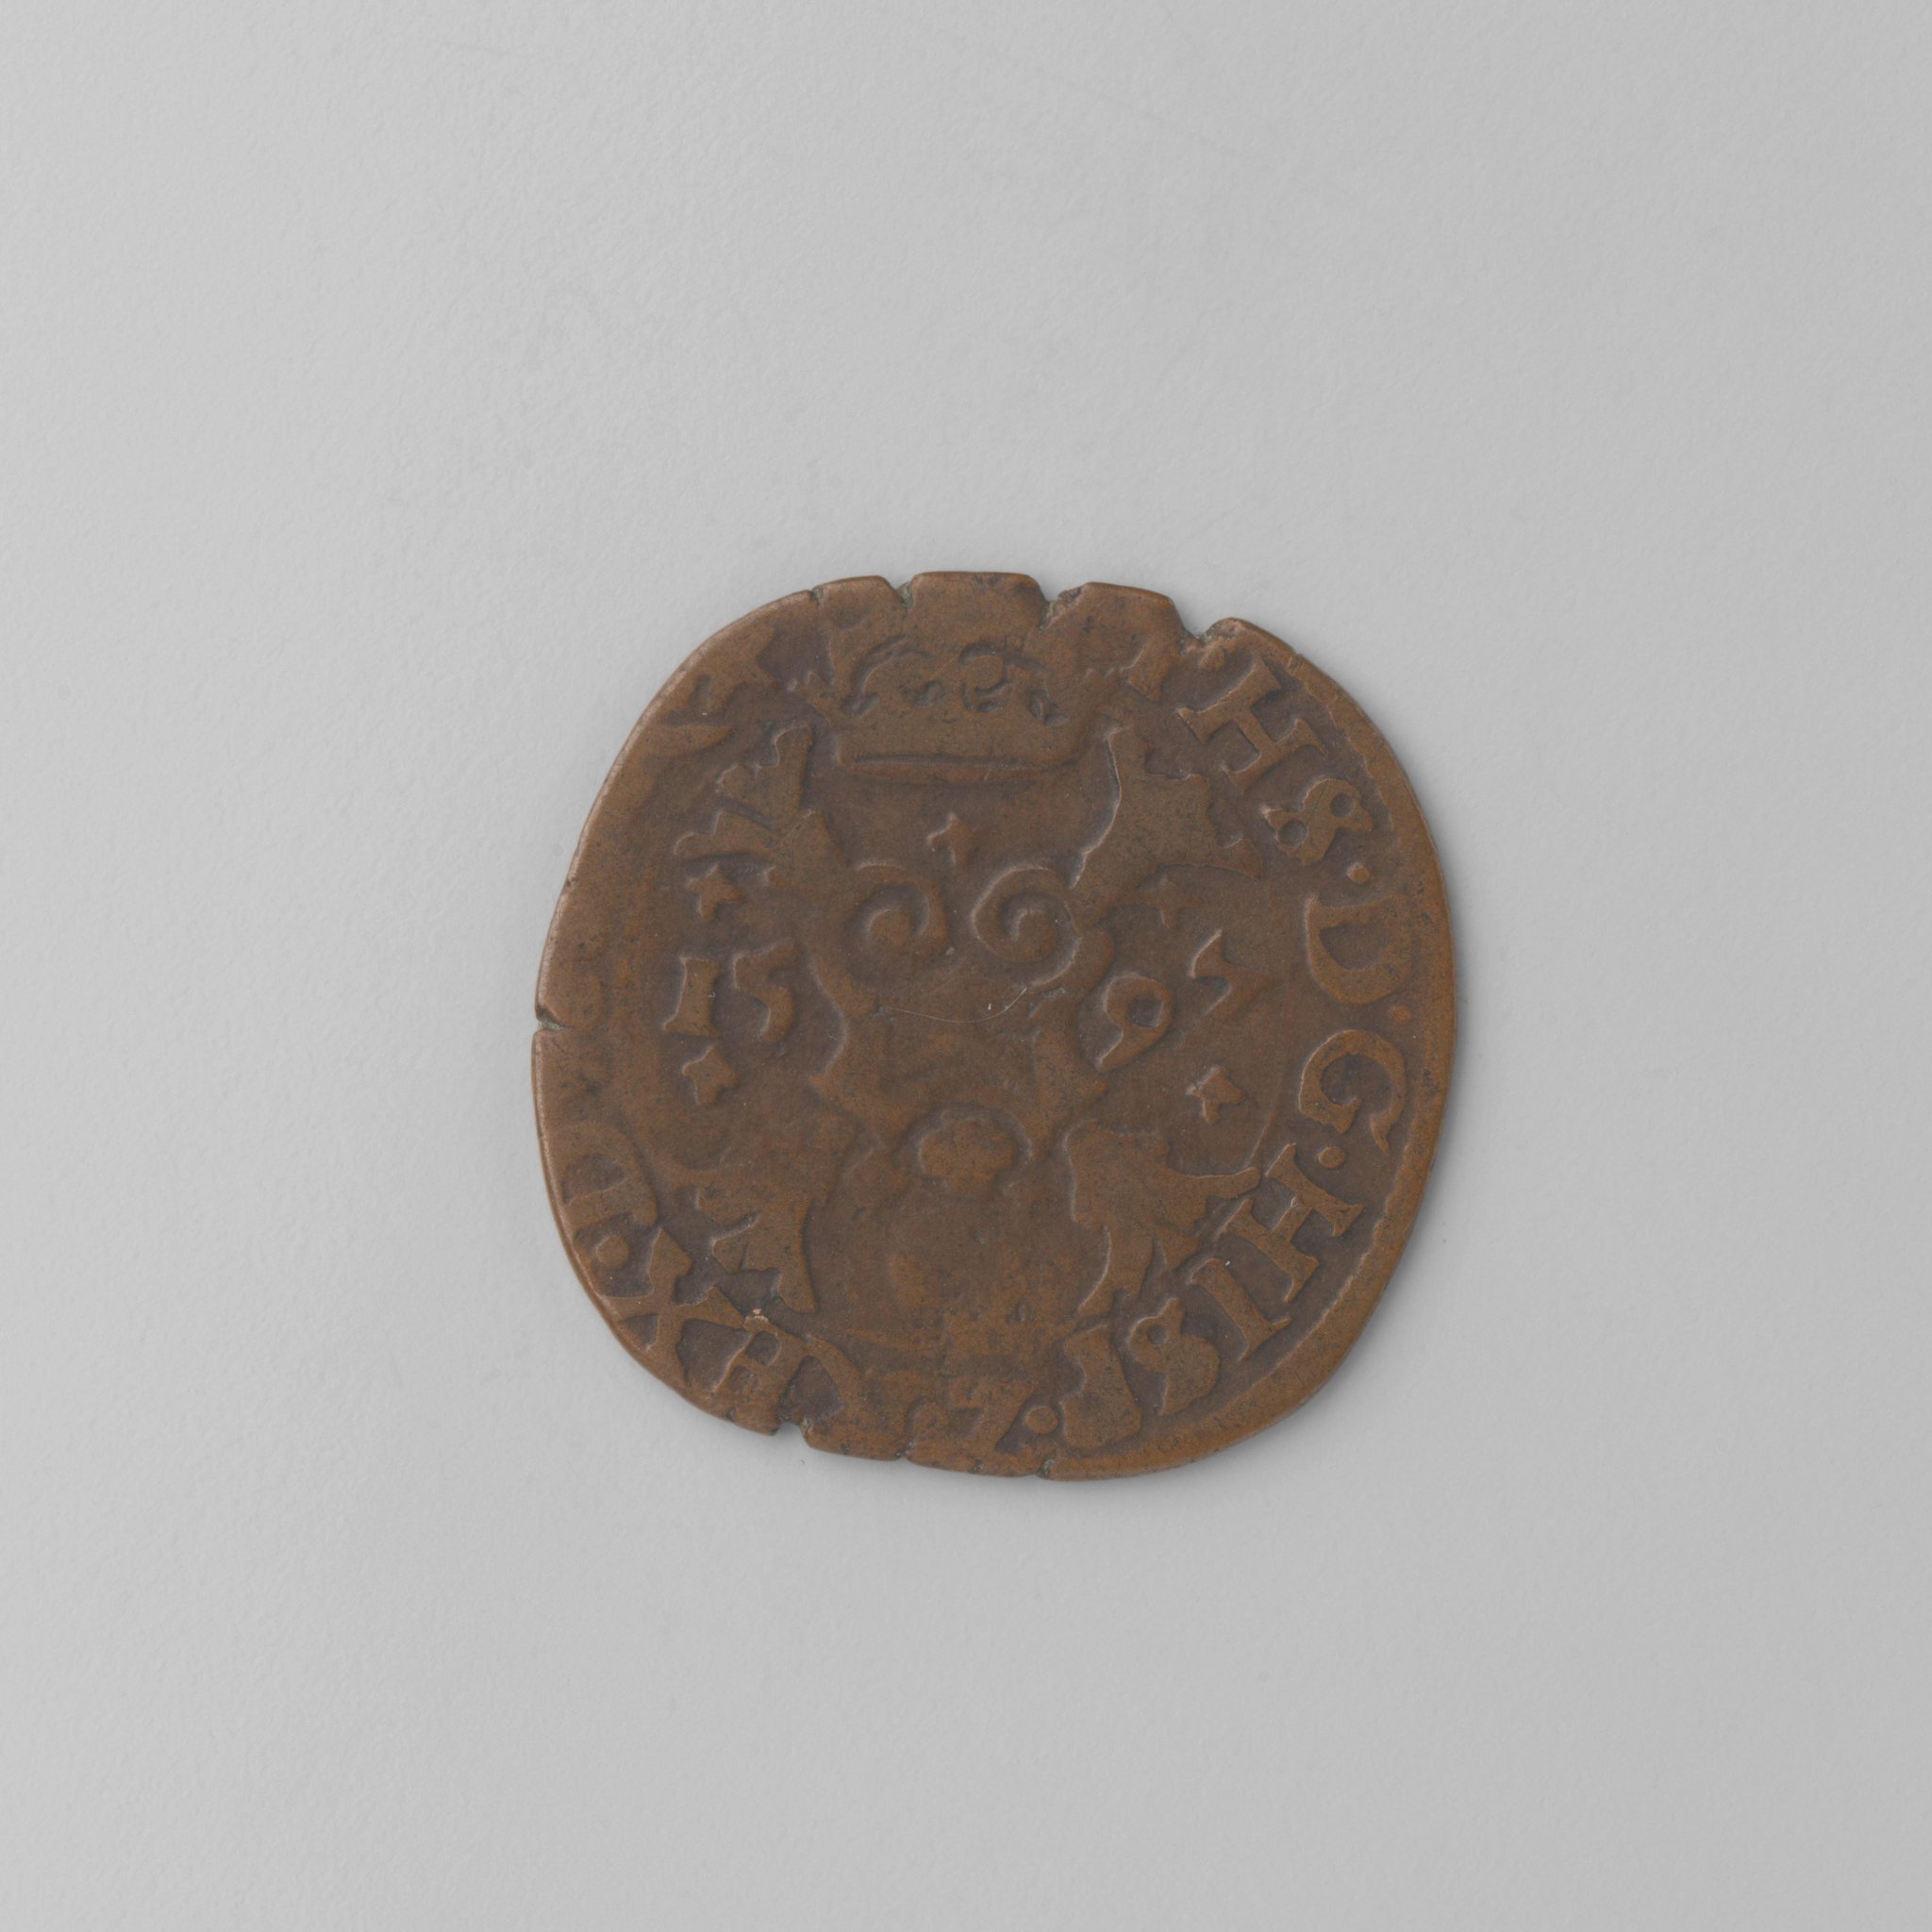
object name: coin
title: Koning Philips II, hertog van Brabant, duit, 1597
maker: hertog van brabant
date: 1597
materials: copper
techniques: striking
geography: maastricht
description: Koperen munt. Voorzijde: tussen jaartal gekroonde vuurslag op stokkenkruis. Aan het eind van het omschrift muntteken: ster [=Maastricht]. Keerzijde: gekroond wapenschild.